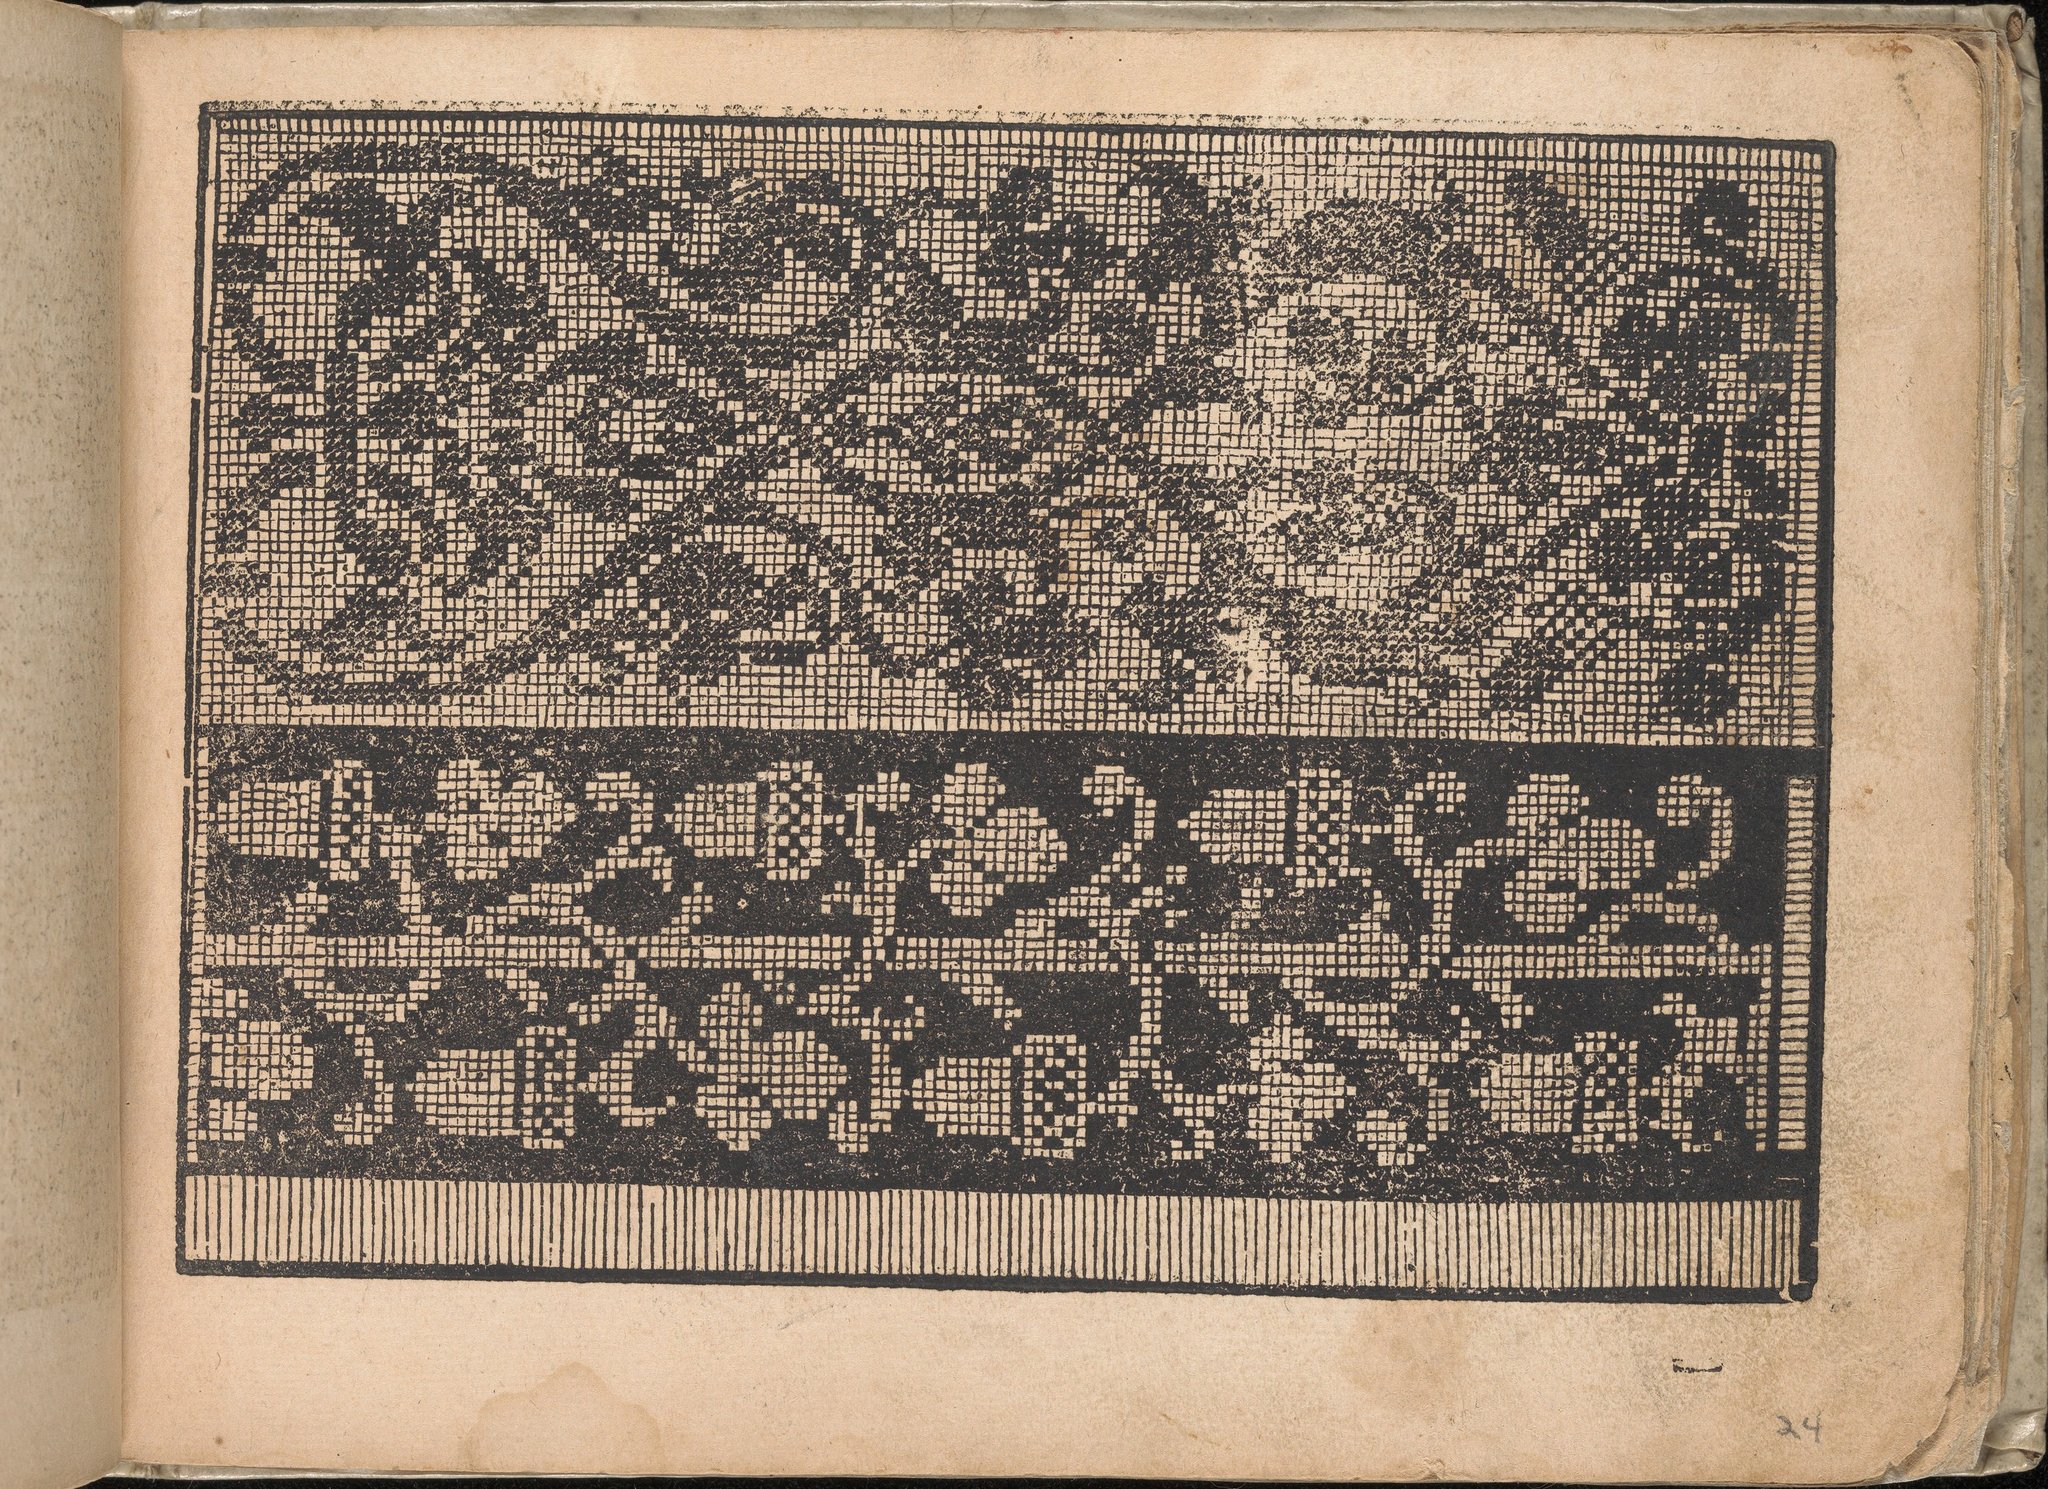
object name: book print ornament architecture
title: Neu künstlich Modelbuch (page 24r)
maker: bernhard jobin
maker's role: publisher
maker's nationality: swiss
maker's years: 1535-1597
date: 1598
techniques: woodcut